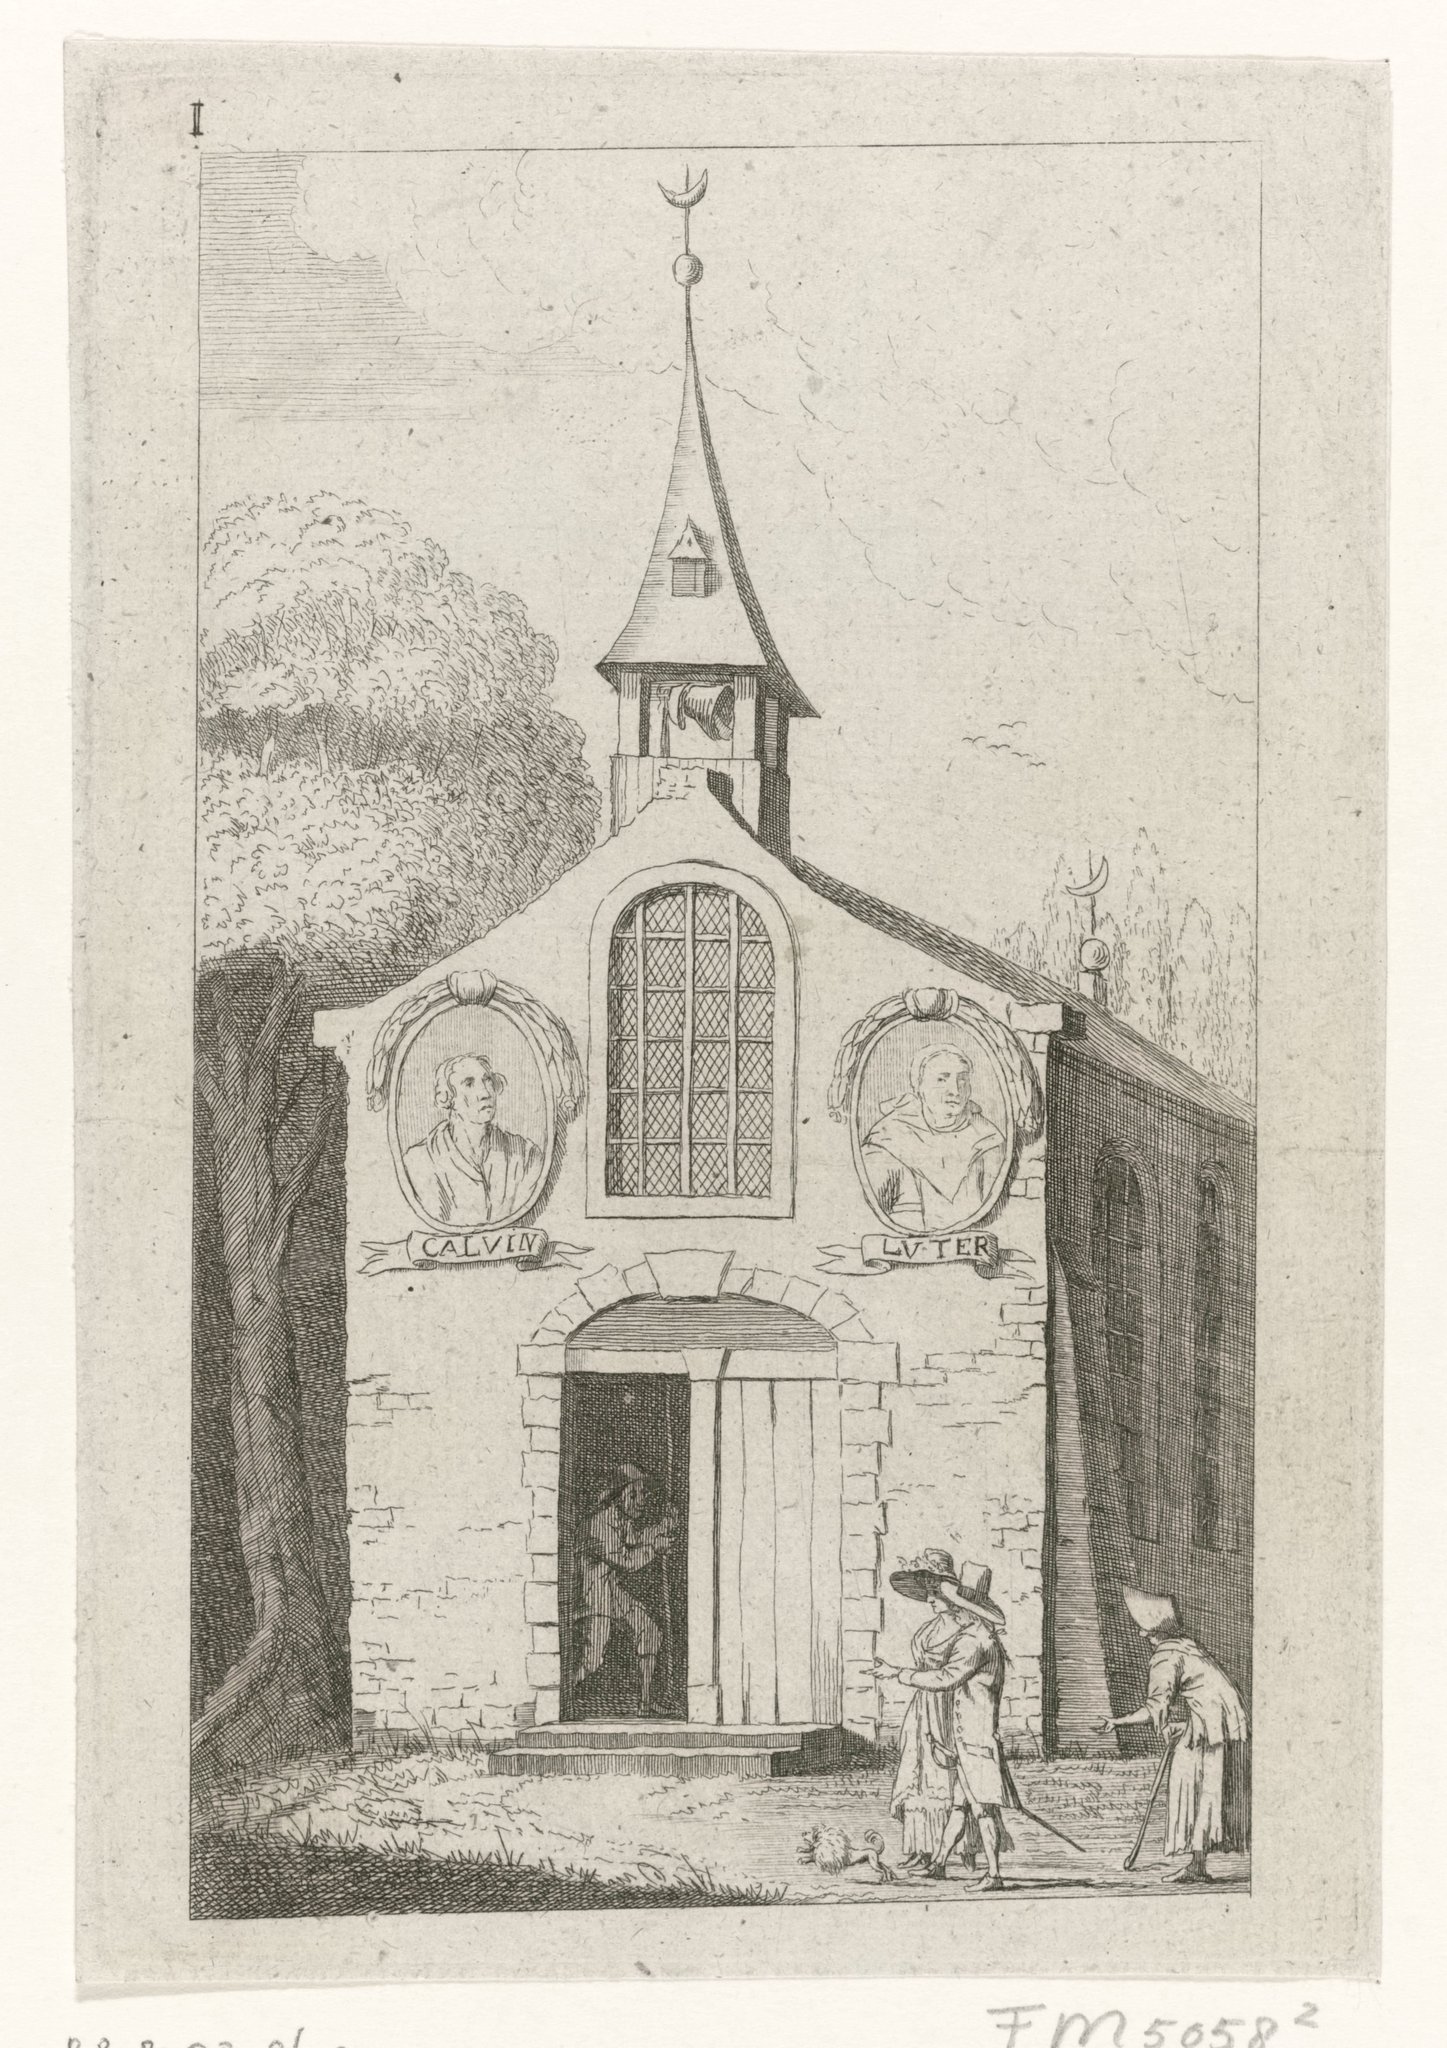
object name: print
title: Brabantse Omwenteling, 1787-1790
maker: Anonymous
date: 1787-1790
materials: paper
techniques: etching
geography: southern netherlands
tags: priest, martin luther, church bell, brabant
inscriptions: collector's mark: Lugt 2228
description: Een kerk met op de gevel twee portretten van de kerkhervormers Calvijn en Luther. Op de torenspits prijkt de halve maan. Binnen een klokkenluider. Genummerd: I. Onderdeel van een grote groep van prenten betrekking hebbend op de gebeurtenissen van de Brabantse Omwenteling en de periode 1787-1790.